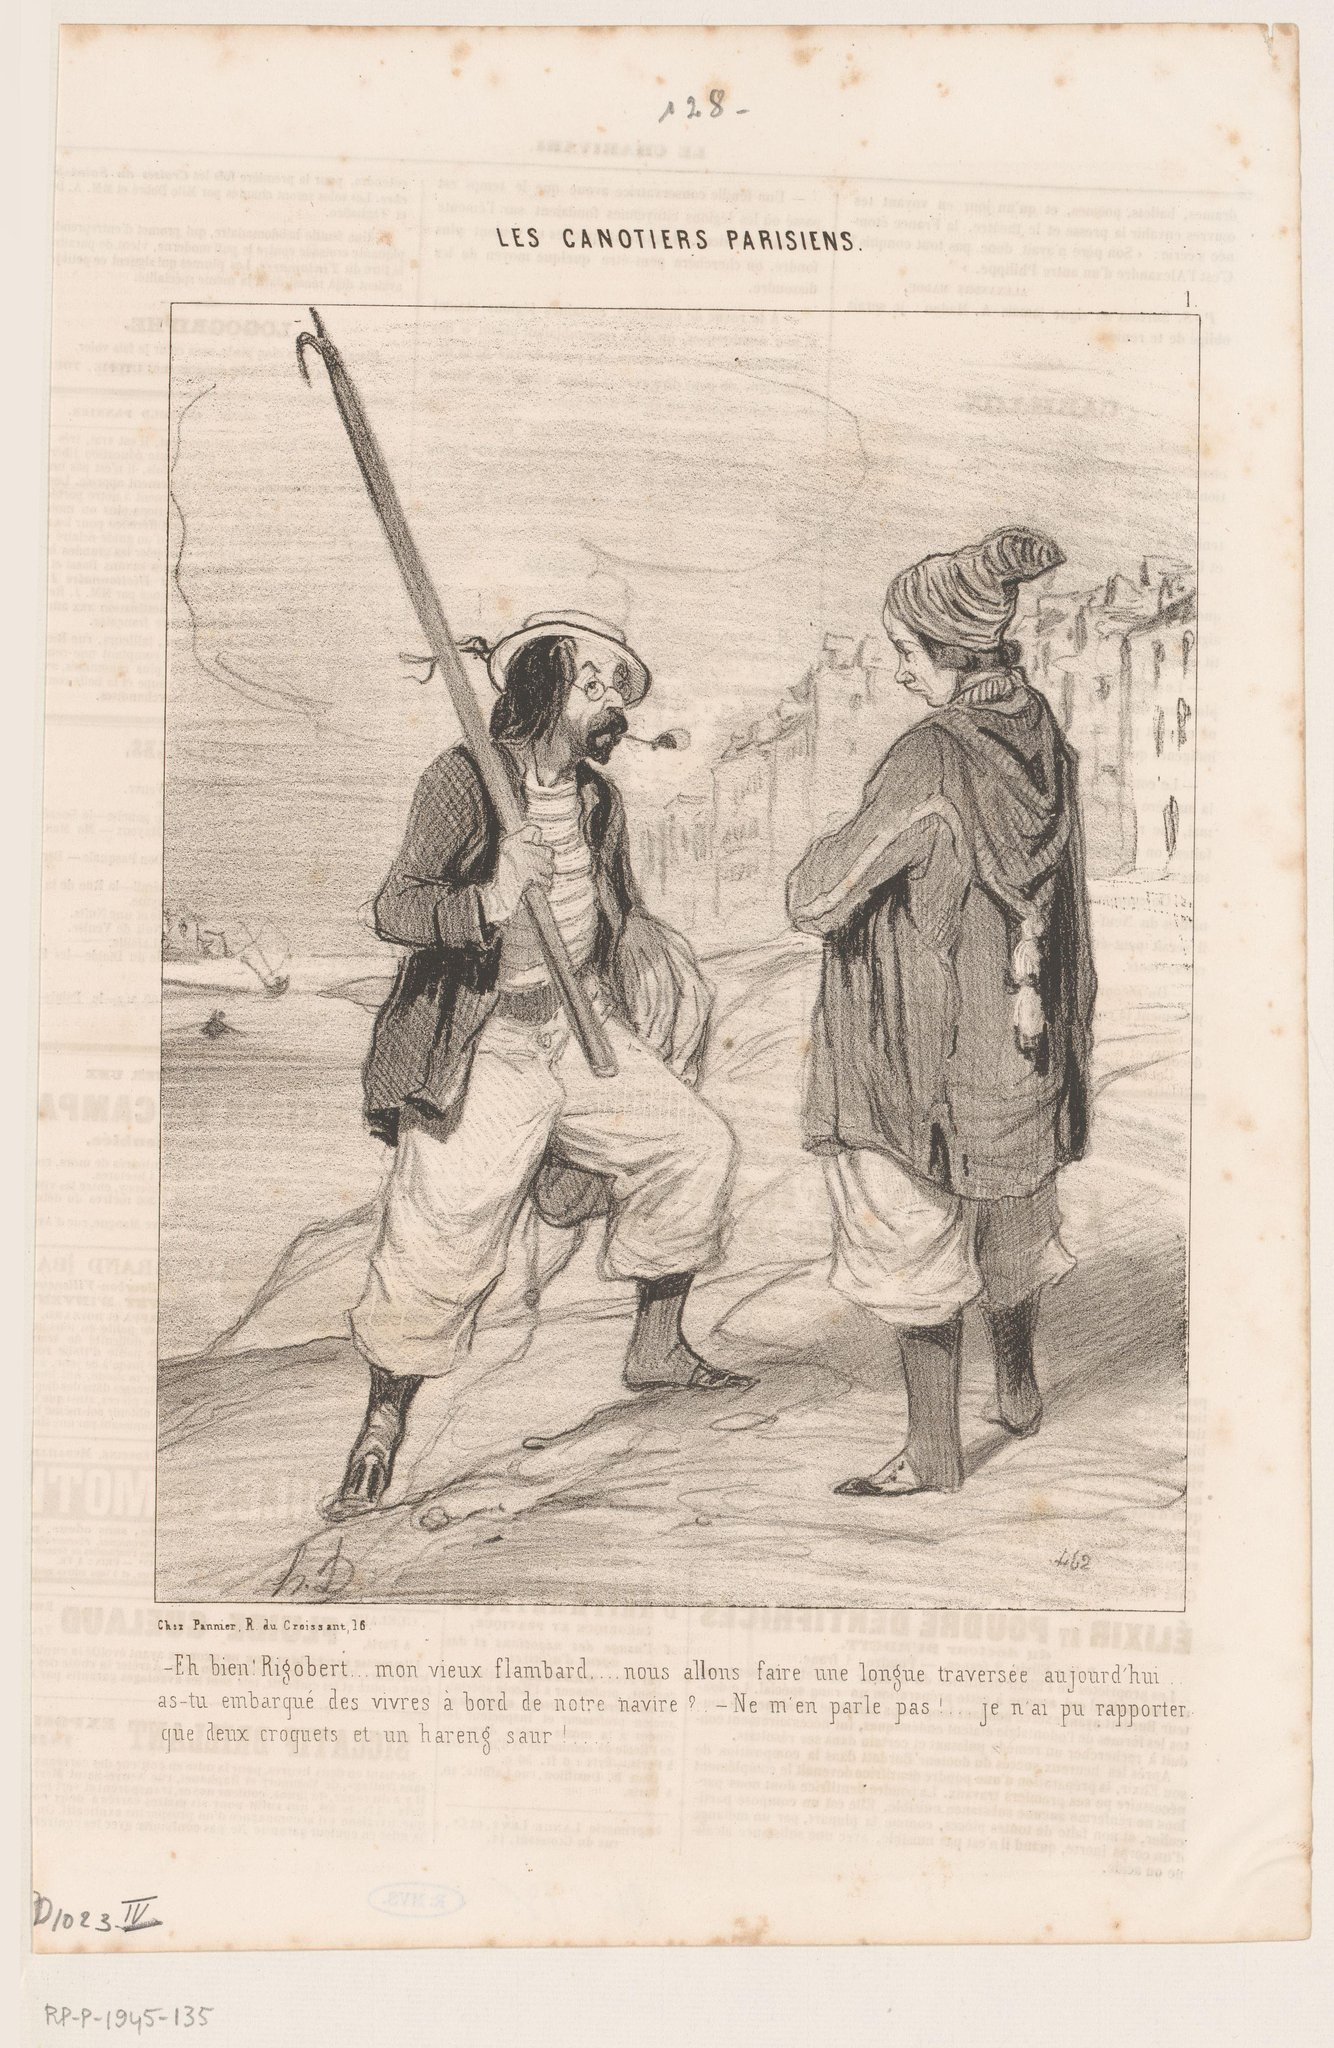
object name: cartoon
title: Les canotiers parisiens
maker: honoré daumier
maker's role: draughtsman, painter, print maker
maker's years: 1808-1879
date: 1843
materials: paper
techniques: lithograph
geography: paris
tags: commercial fishery, caricatures (human types), river, paris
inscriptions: collector's mark: Lugt 2228a, number: ‘128’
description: Prent gepubliceerd in: Le Charivari, Aubert: Parijs, 11-04-1843. Le Charivari was een humoristische krant met karikaturen en (politieke) cartoons.